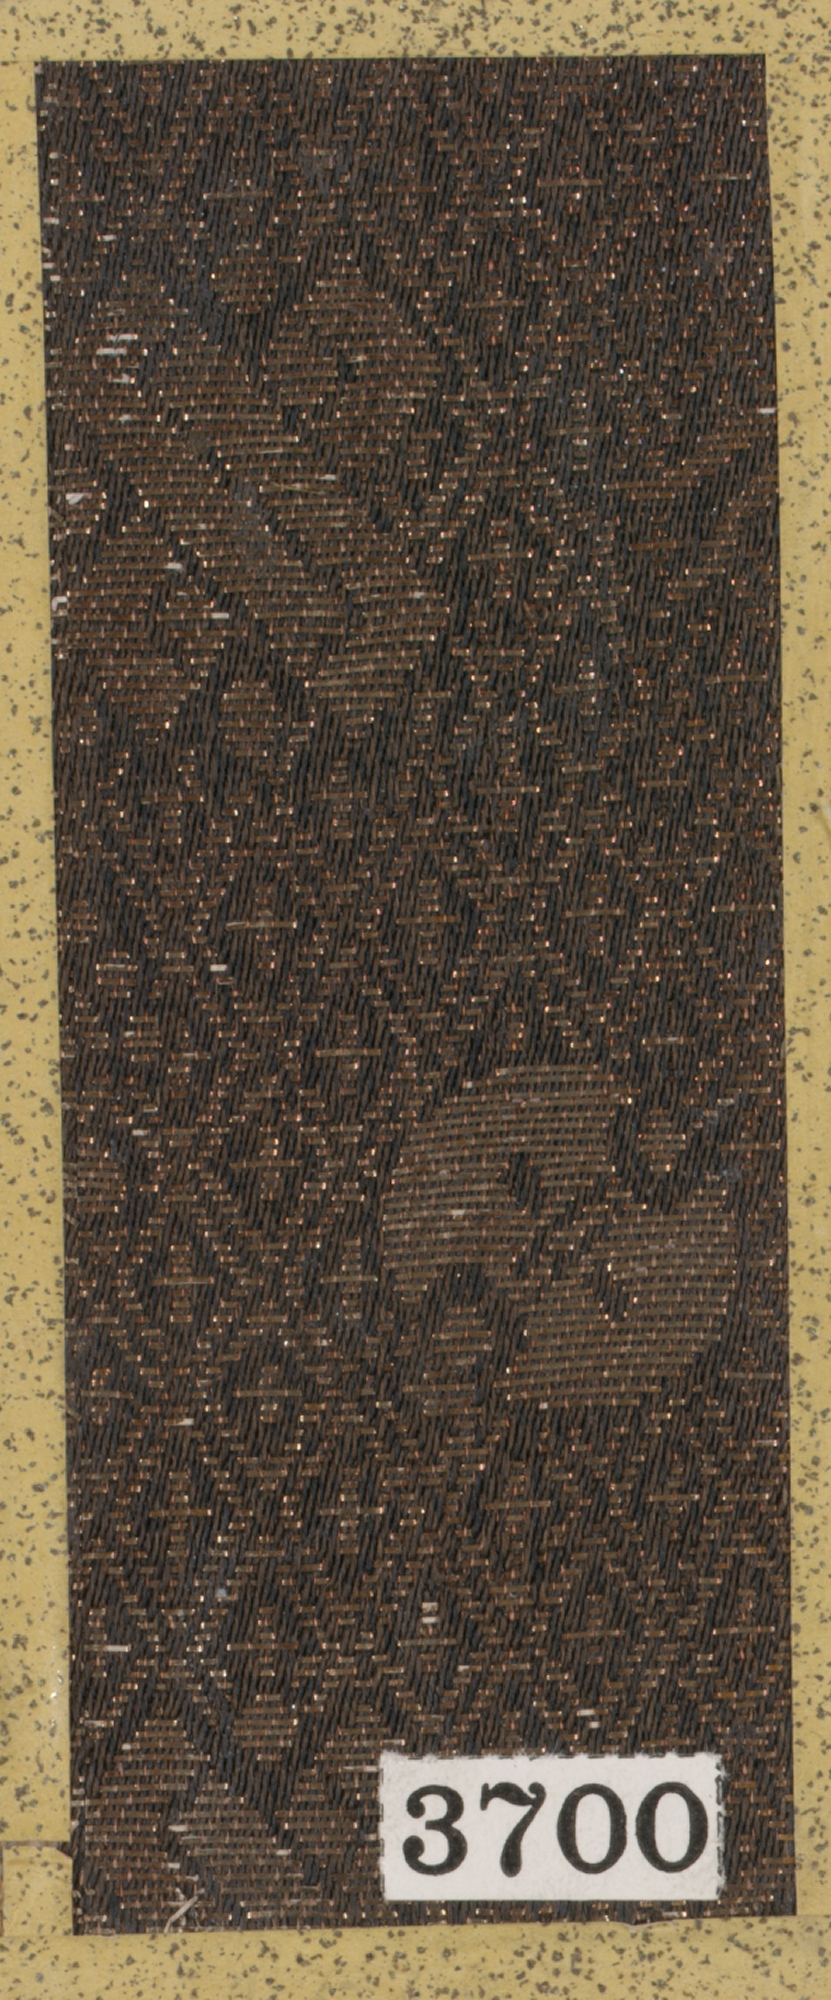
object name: piece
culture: japanese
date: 1801-1900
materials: silk